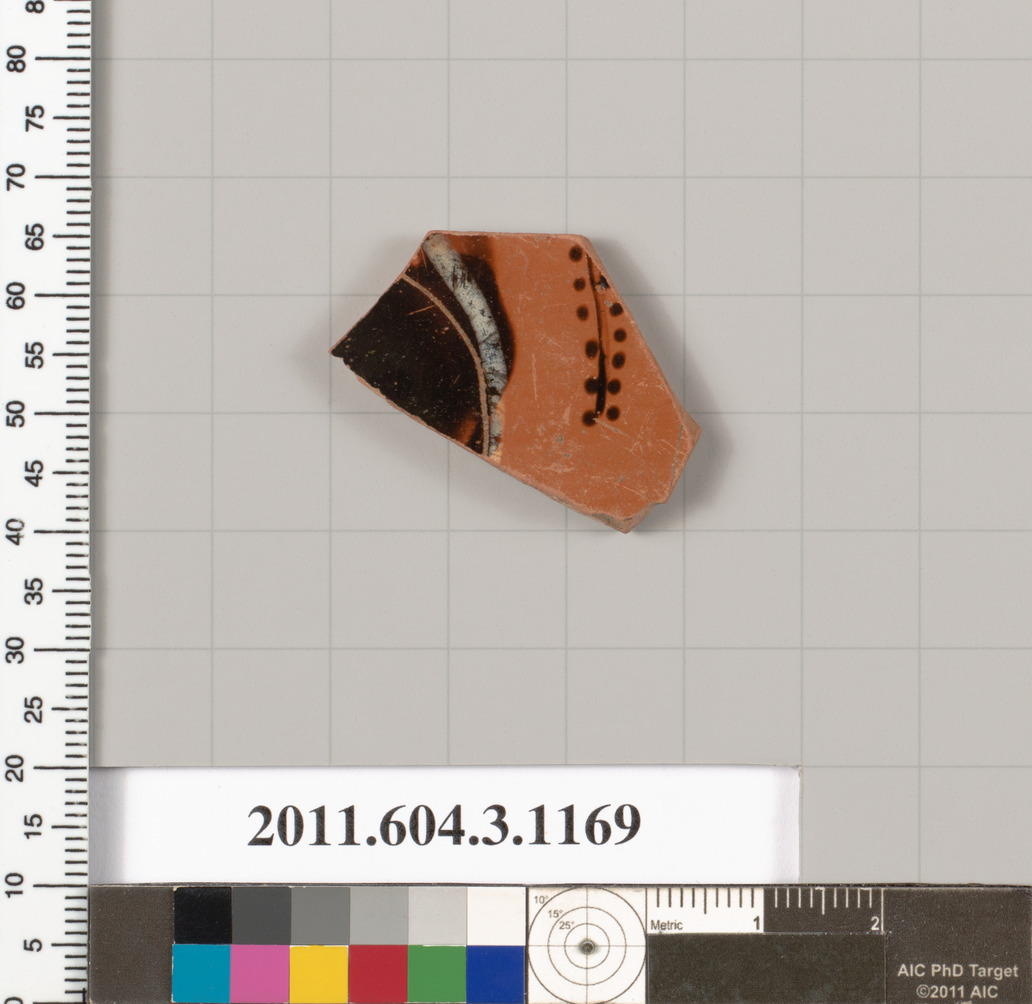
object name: mastoid or kyathos fragment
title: Terracotta fragment of a mastoid (drinking cup with narrow base) or a kyathos (cup-shaped ladle)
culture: greek, attic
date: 534-468 BCE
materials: terracotta